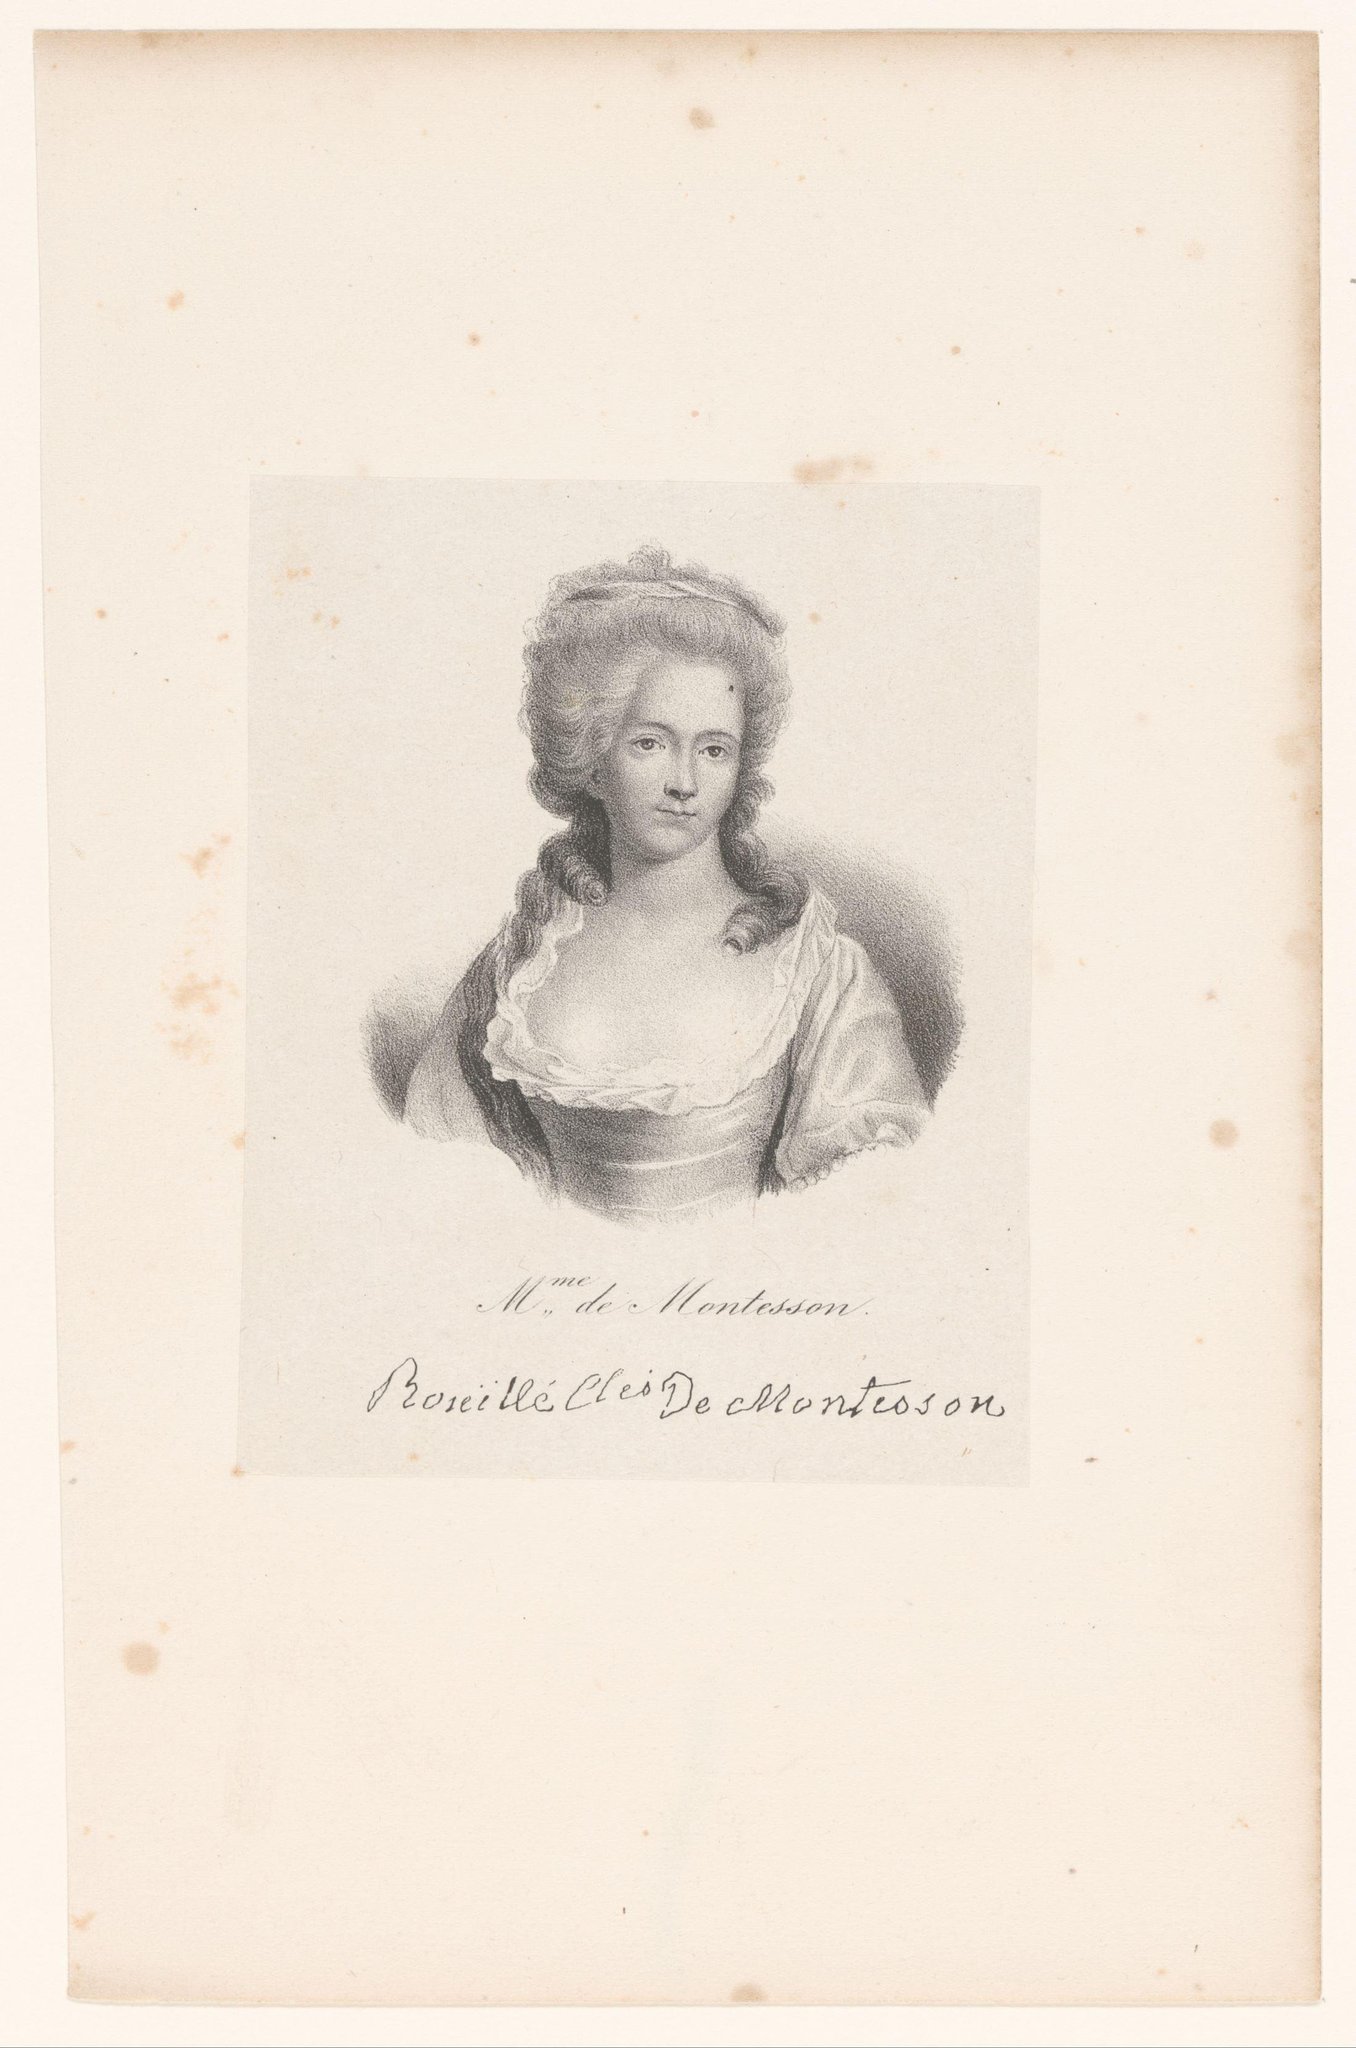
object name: print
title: M.me de Montesson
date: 1818-1842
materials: paper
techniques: lithograph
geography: paris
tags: historical persons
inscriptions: collector's mark: Lugt 2228a